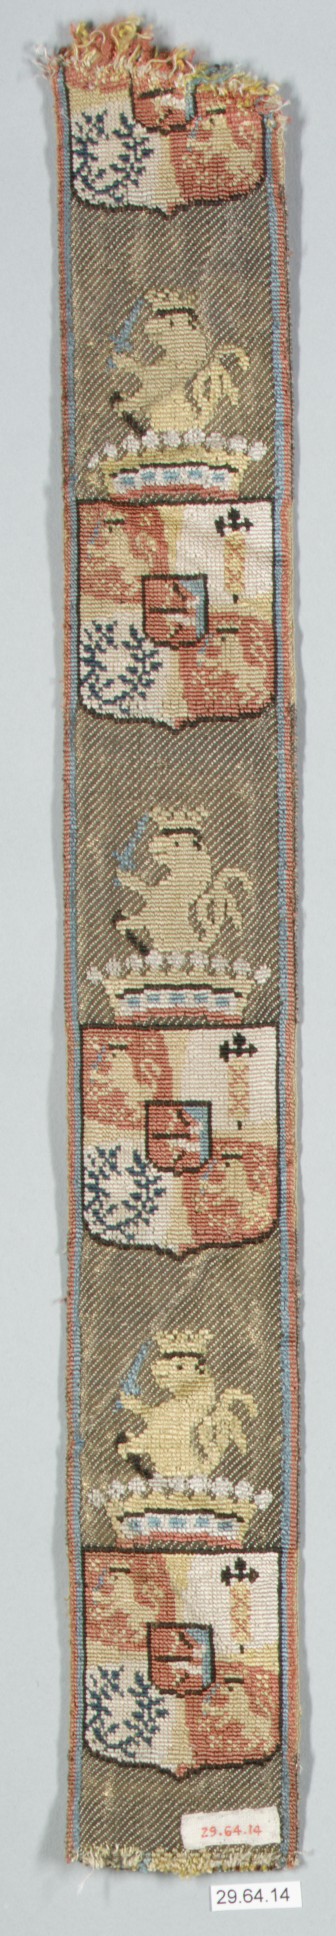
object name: galloon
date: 1701-1900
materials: metal thread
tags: coat of arms